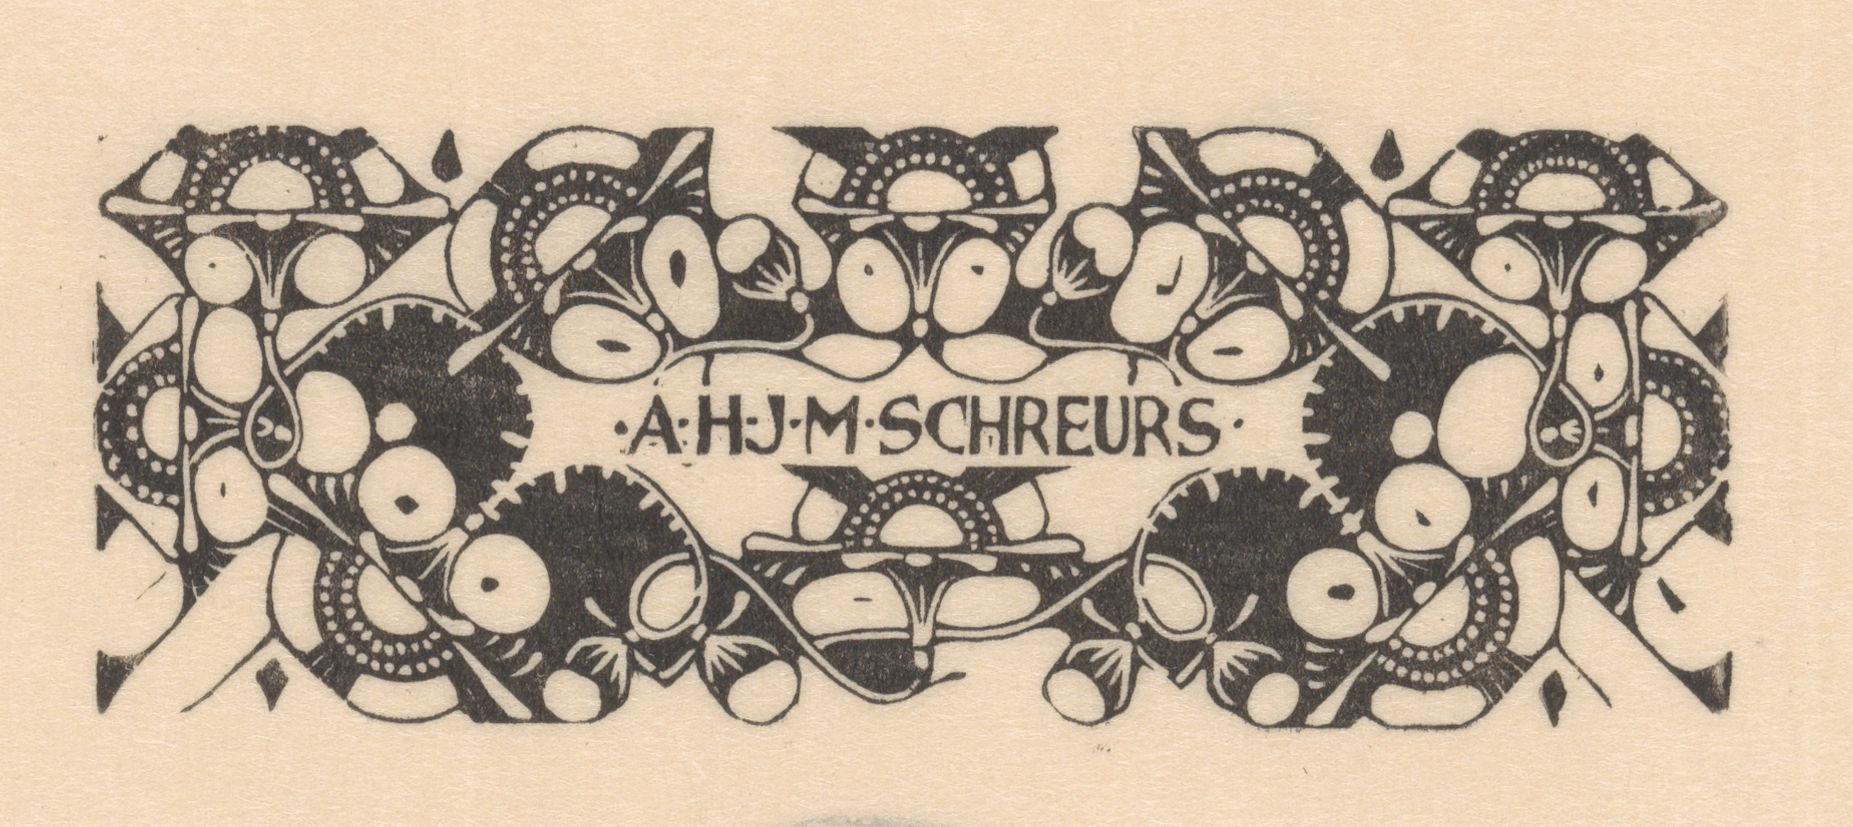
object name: print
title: Visitekaartje van A.H.J.M. Schreurs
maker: mathieu lauweriks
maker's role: designer, draughtsman, print maker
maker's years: 1864-1932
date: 1896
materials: paper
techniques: woodcut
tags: antoine h.j.m. schreurs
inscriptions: collector's mark: Lugt 2228